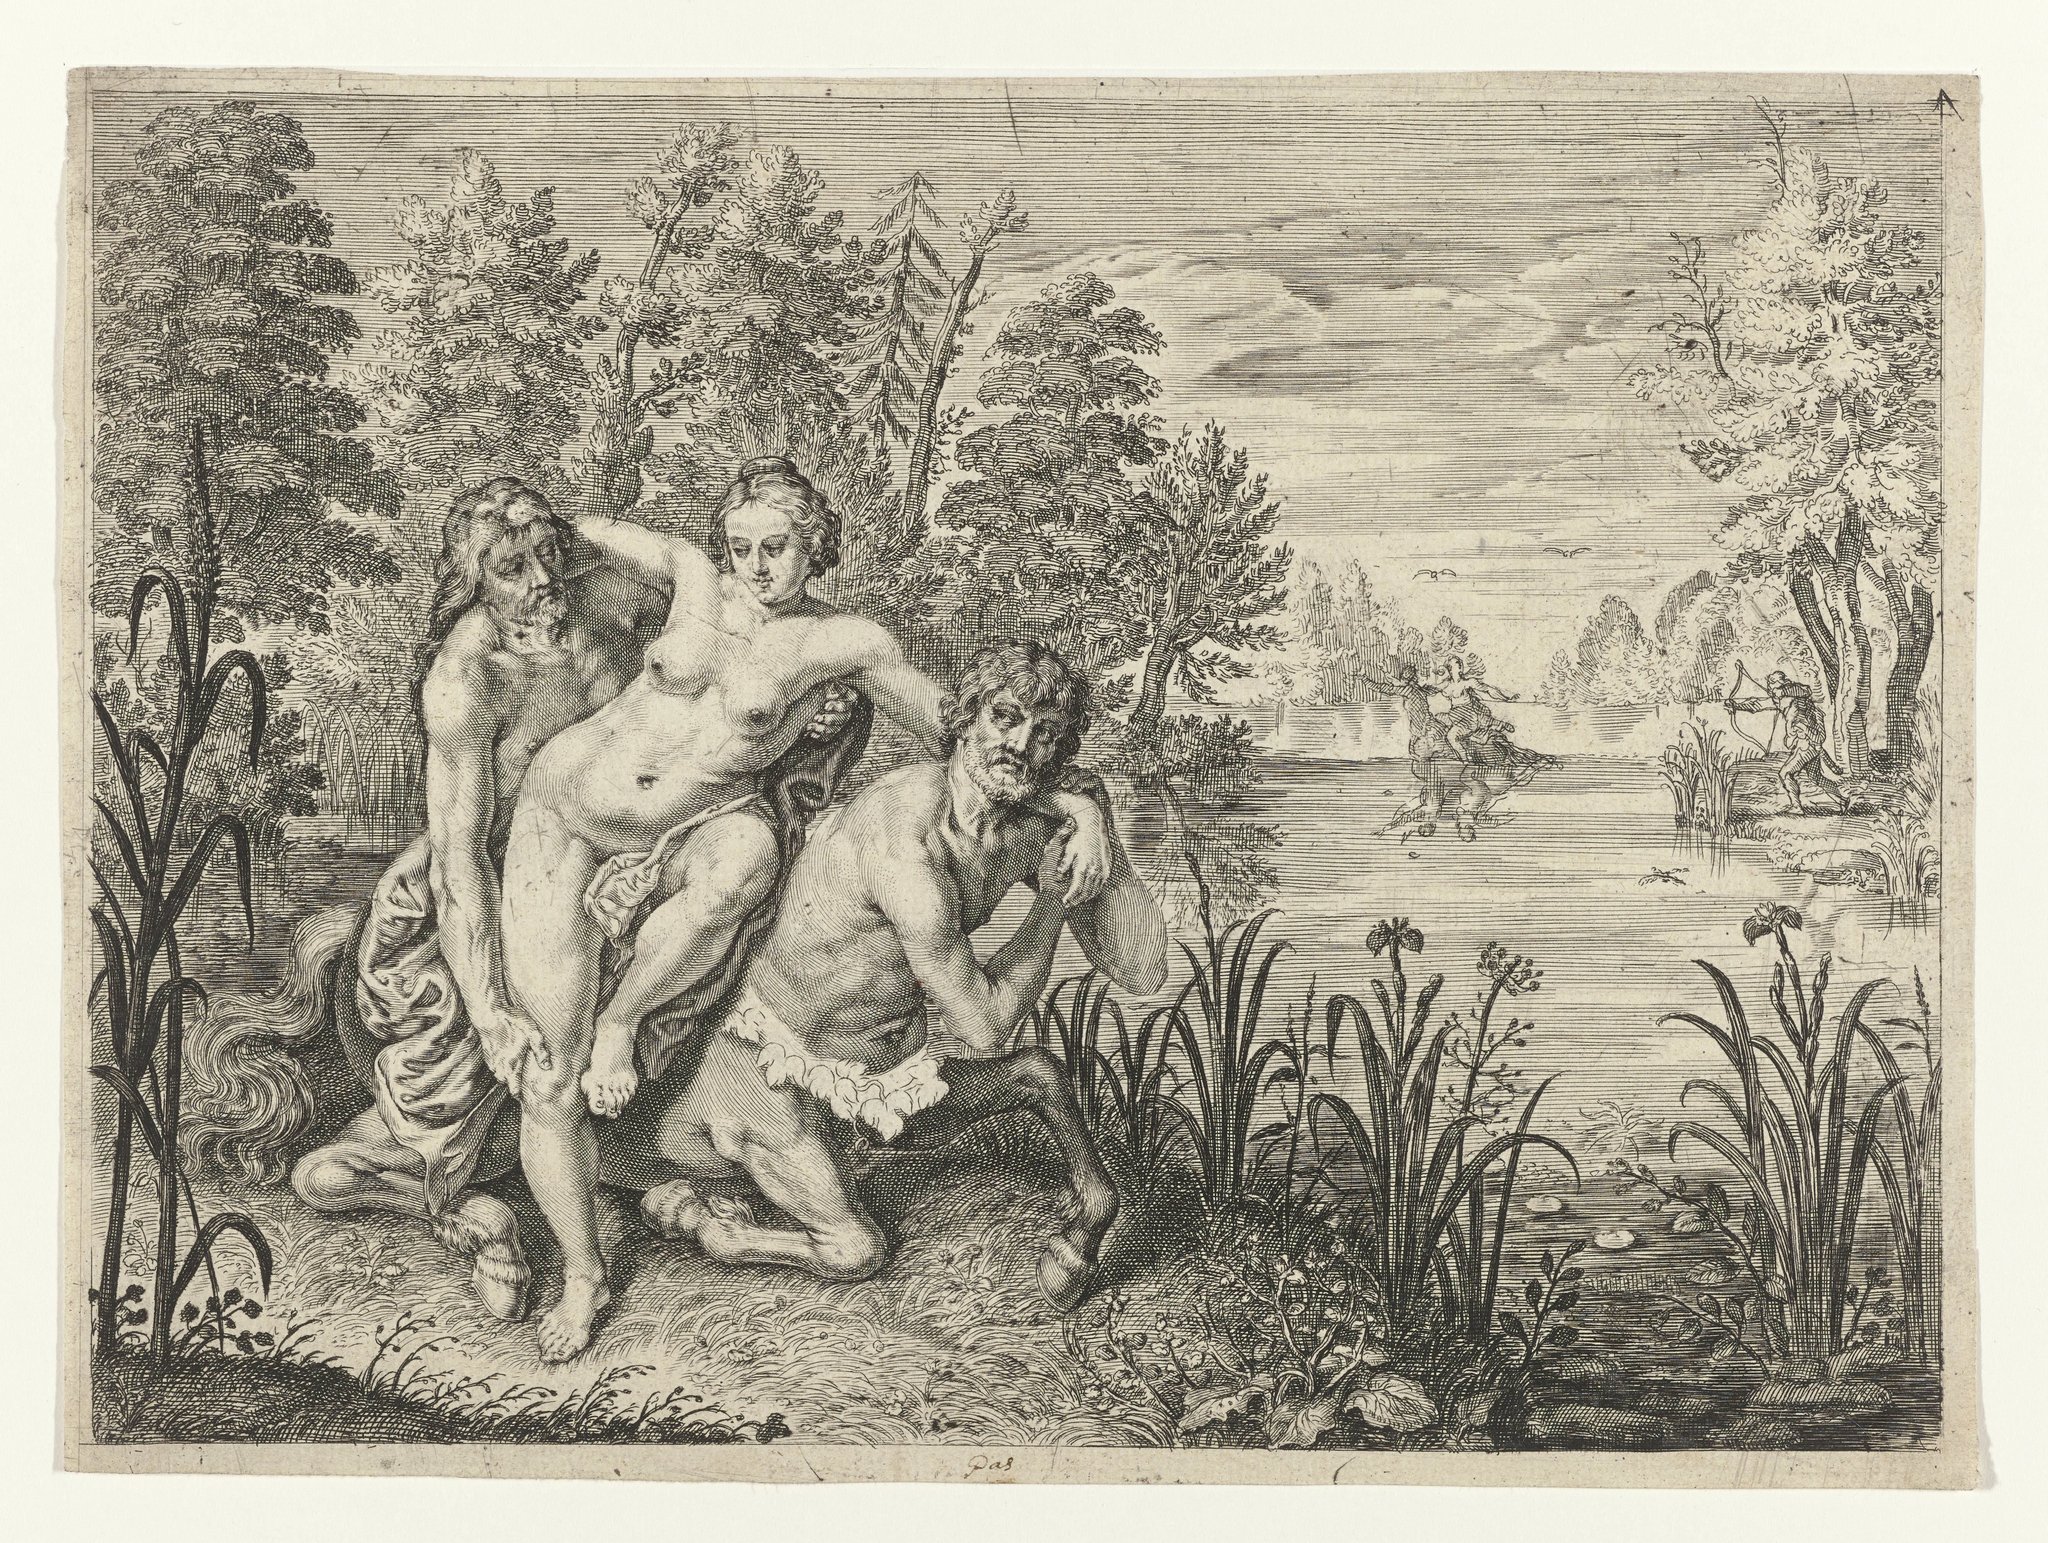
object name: print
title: Metamorfosen van Ovidius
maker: crispijn van de passe (ii)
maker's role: draughtsman, print maker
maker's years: 1594-1670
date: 1636-1670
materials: paper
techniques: engraving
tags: hercules shoots nessus, the centaur, who attempts to carry off deianira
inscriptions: number: ‘57’, annotation: ‘Pas’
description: De ambitieuze reeks naar ontwerpen van ondermeer Jacob Pynas, Roeland Savery, Pieter Clouwet, Rubens en Rembrandt is nooit voltooid door de De Passes. De reeks werd uiteindelijk in 1677 in boekvorm uitgegeven in Brussel door Piere Du Rayer en Francois Foppes. Als losse prenten is de reeks alleen bekend uit een groep prenten afkomstig uit de collectie Hinloopen (1619-1708) die zich in het Rijksprentenkabinet bevindt. Deze groep is uitgebreid beschreven door Jan van der Waals in zijn Hinloopen-catalogus (zie: ''Een onbekende editie van een serie Ovidius-illustraties'' in De prentschat van Michiel Hinloopen, 1988, p. 79-102.). De ontdekking van een tweede groep afdrukken van de reeks, afkomstig uit de werkplaats van Crispijn de Passe de Jonge, biedt een belangrijke aanvulling op de Hinloopen-groep. Sommige afdrukken tonen de prenten in onvoltooide staat en zijn voorzien van verbeteringen en toevoegingen in pen en penseel. Bovendien zijn alle prenten voorzien van 17de-eeuwse opschriften die het in een aantal gevallen mogelijk maakt de ontwerpers van de voorstellingen nader te identificeren. Op grond van de aangetroffen watermerken kunnen de afdrukken worden gedateerd omstreeks 1652-1653.